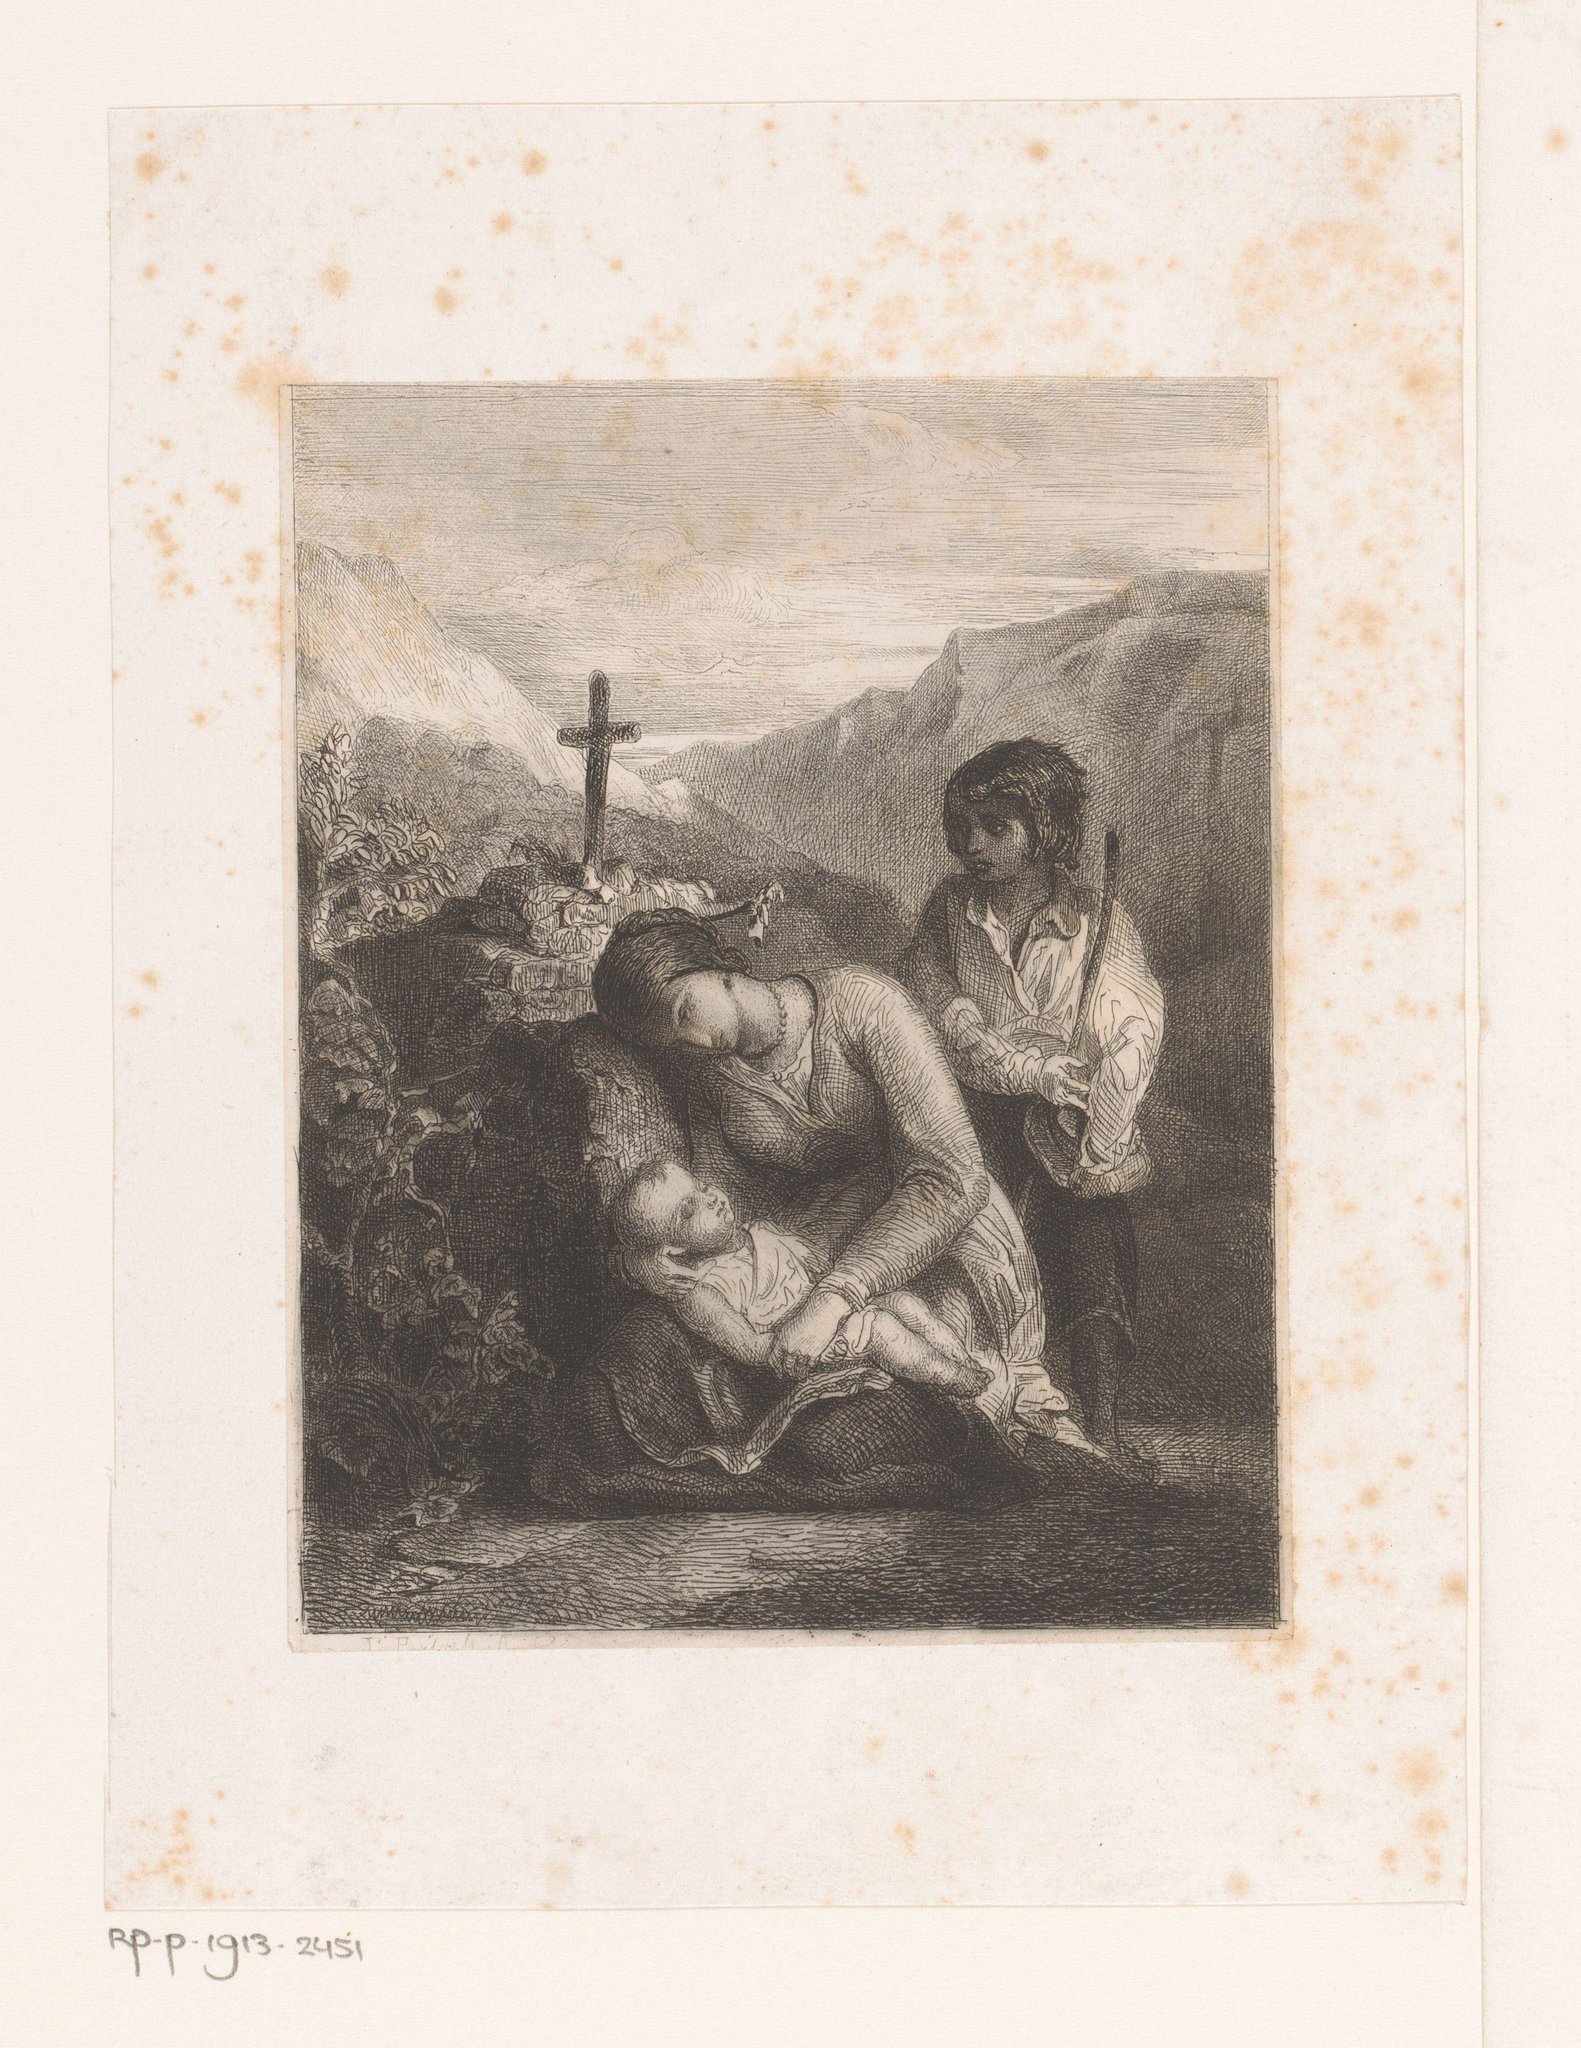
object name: print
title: Moeder met twee kinderen aan de voet van een kruis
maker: jean françois portaels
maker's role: print maker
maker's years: 1818-1895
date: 1828-1895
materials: paper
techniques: etching, intaglio, engraving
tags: the cross ~ symbols of christ, mother with son(s) (mother-love), one person praying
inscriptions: collector's mark: Lugt 2228, collector's mark: Lugt 1485